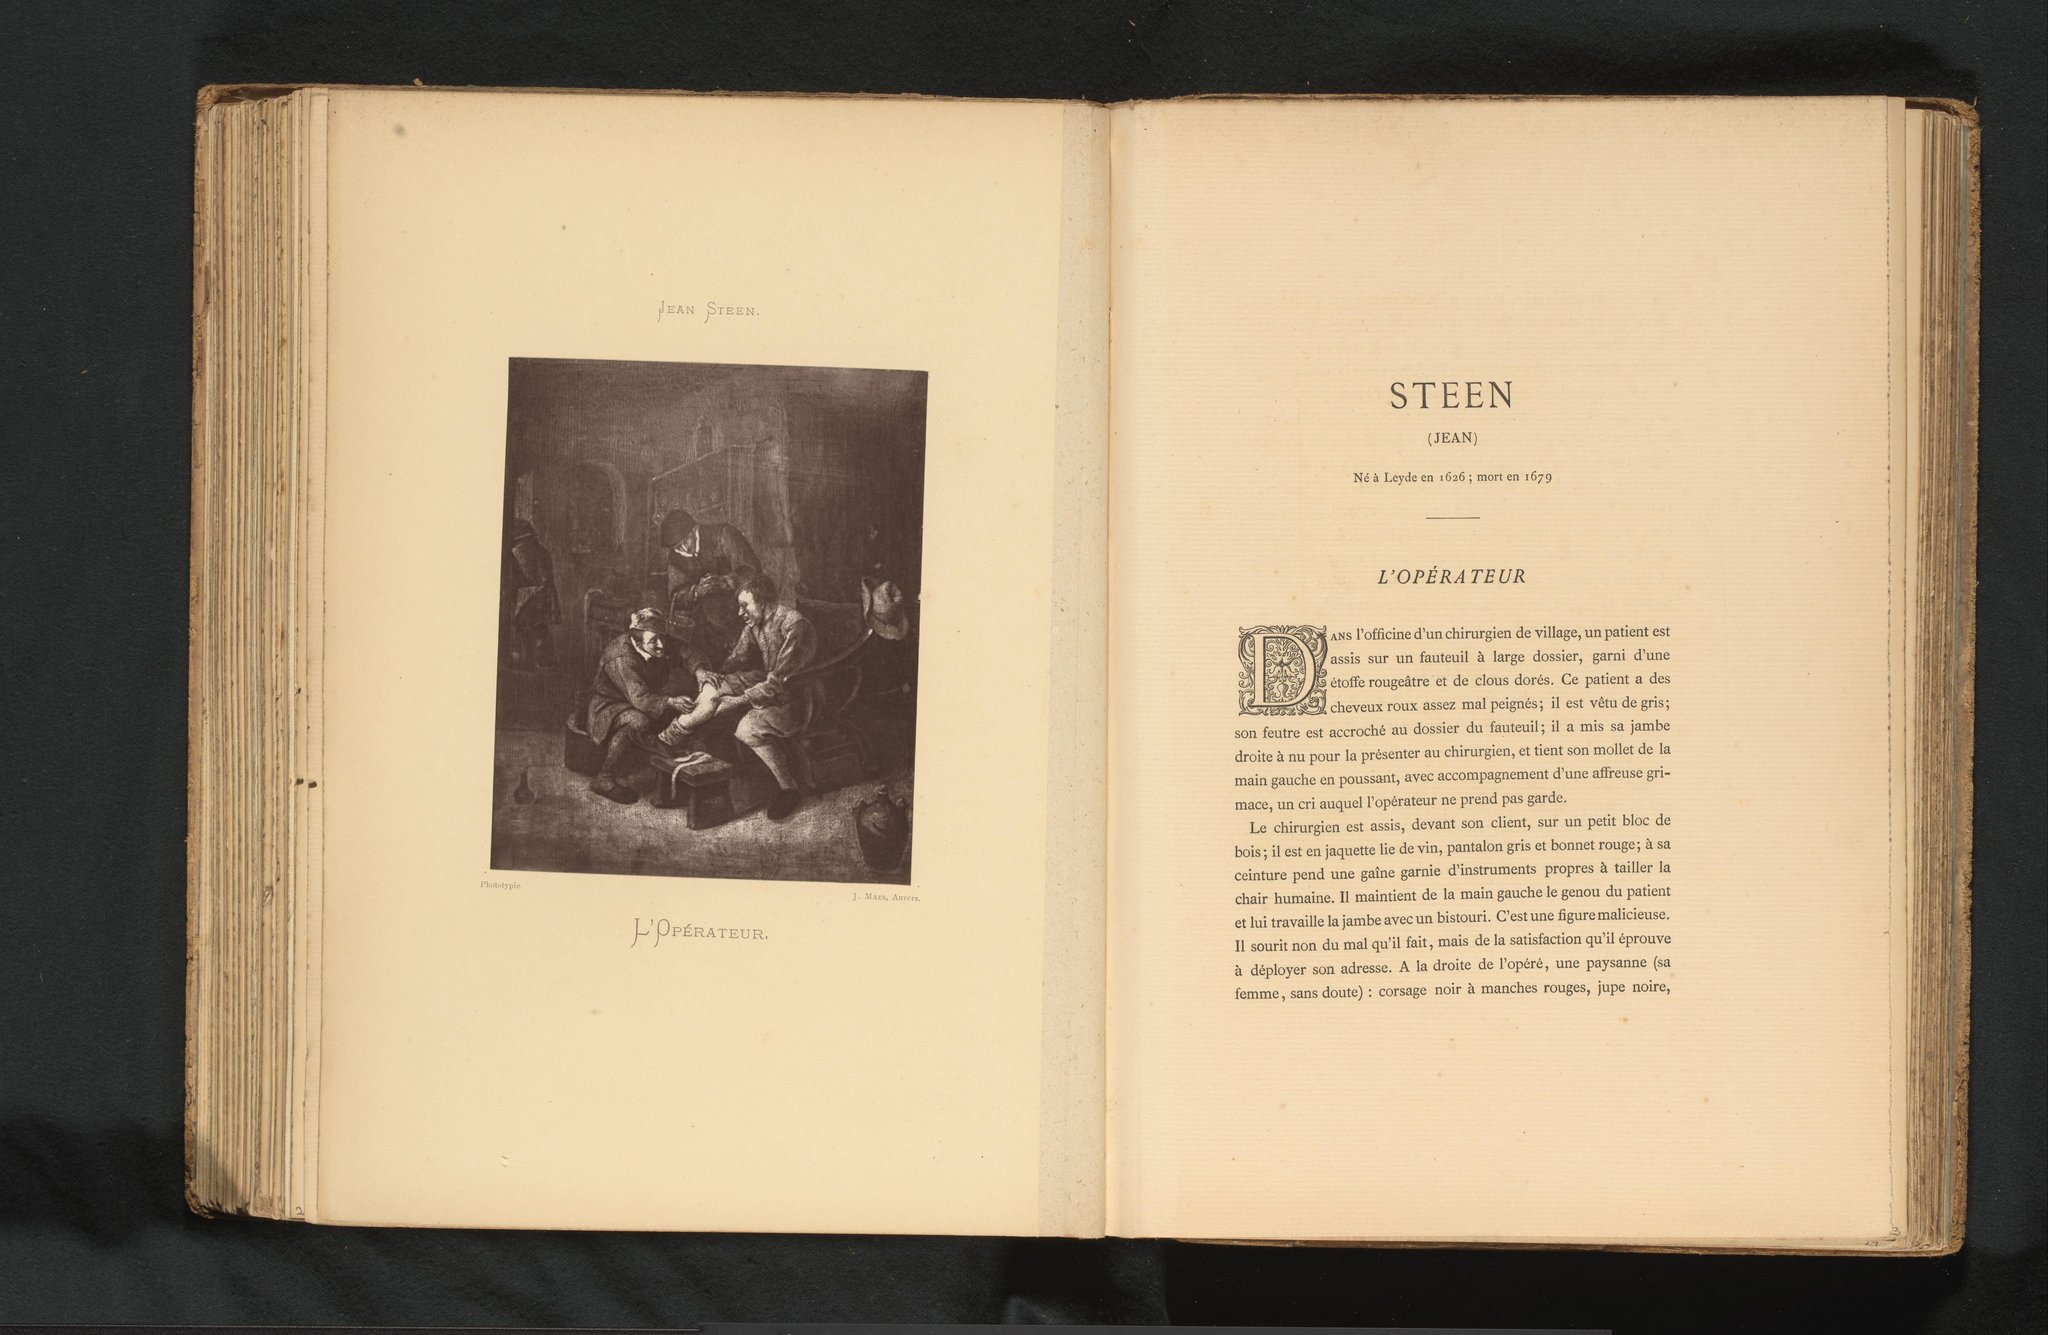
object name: photomechanical print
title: L'Opérateur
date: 1873-1878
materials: paper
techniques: woodburytype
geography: antwerp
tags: physician, doctor, patient, sick person